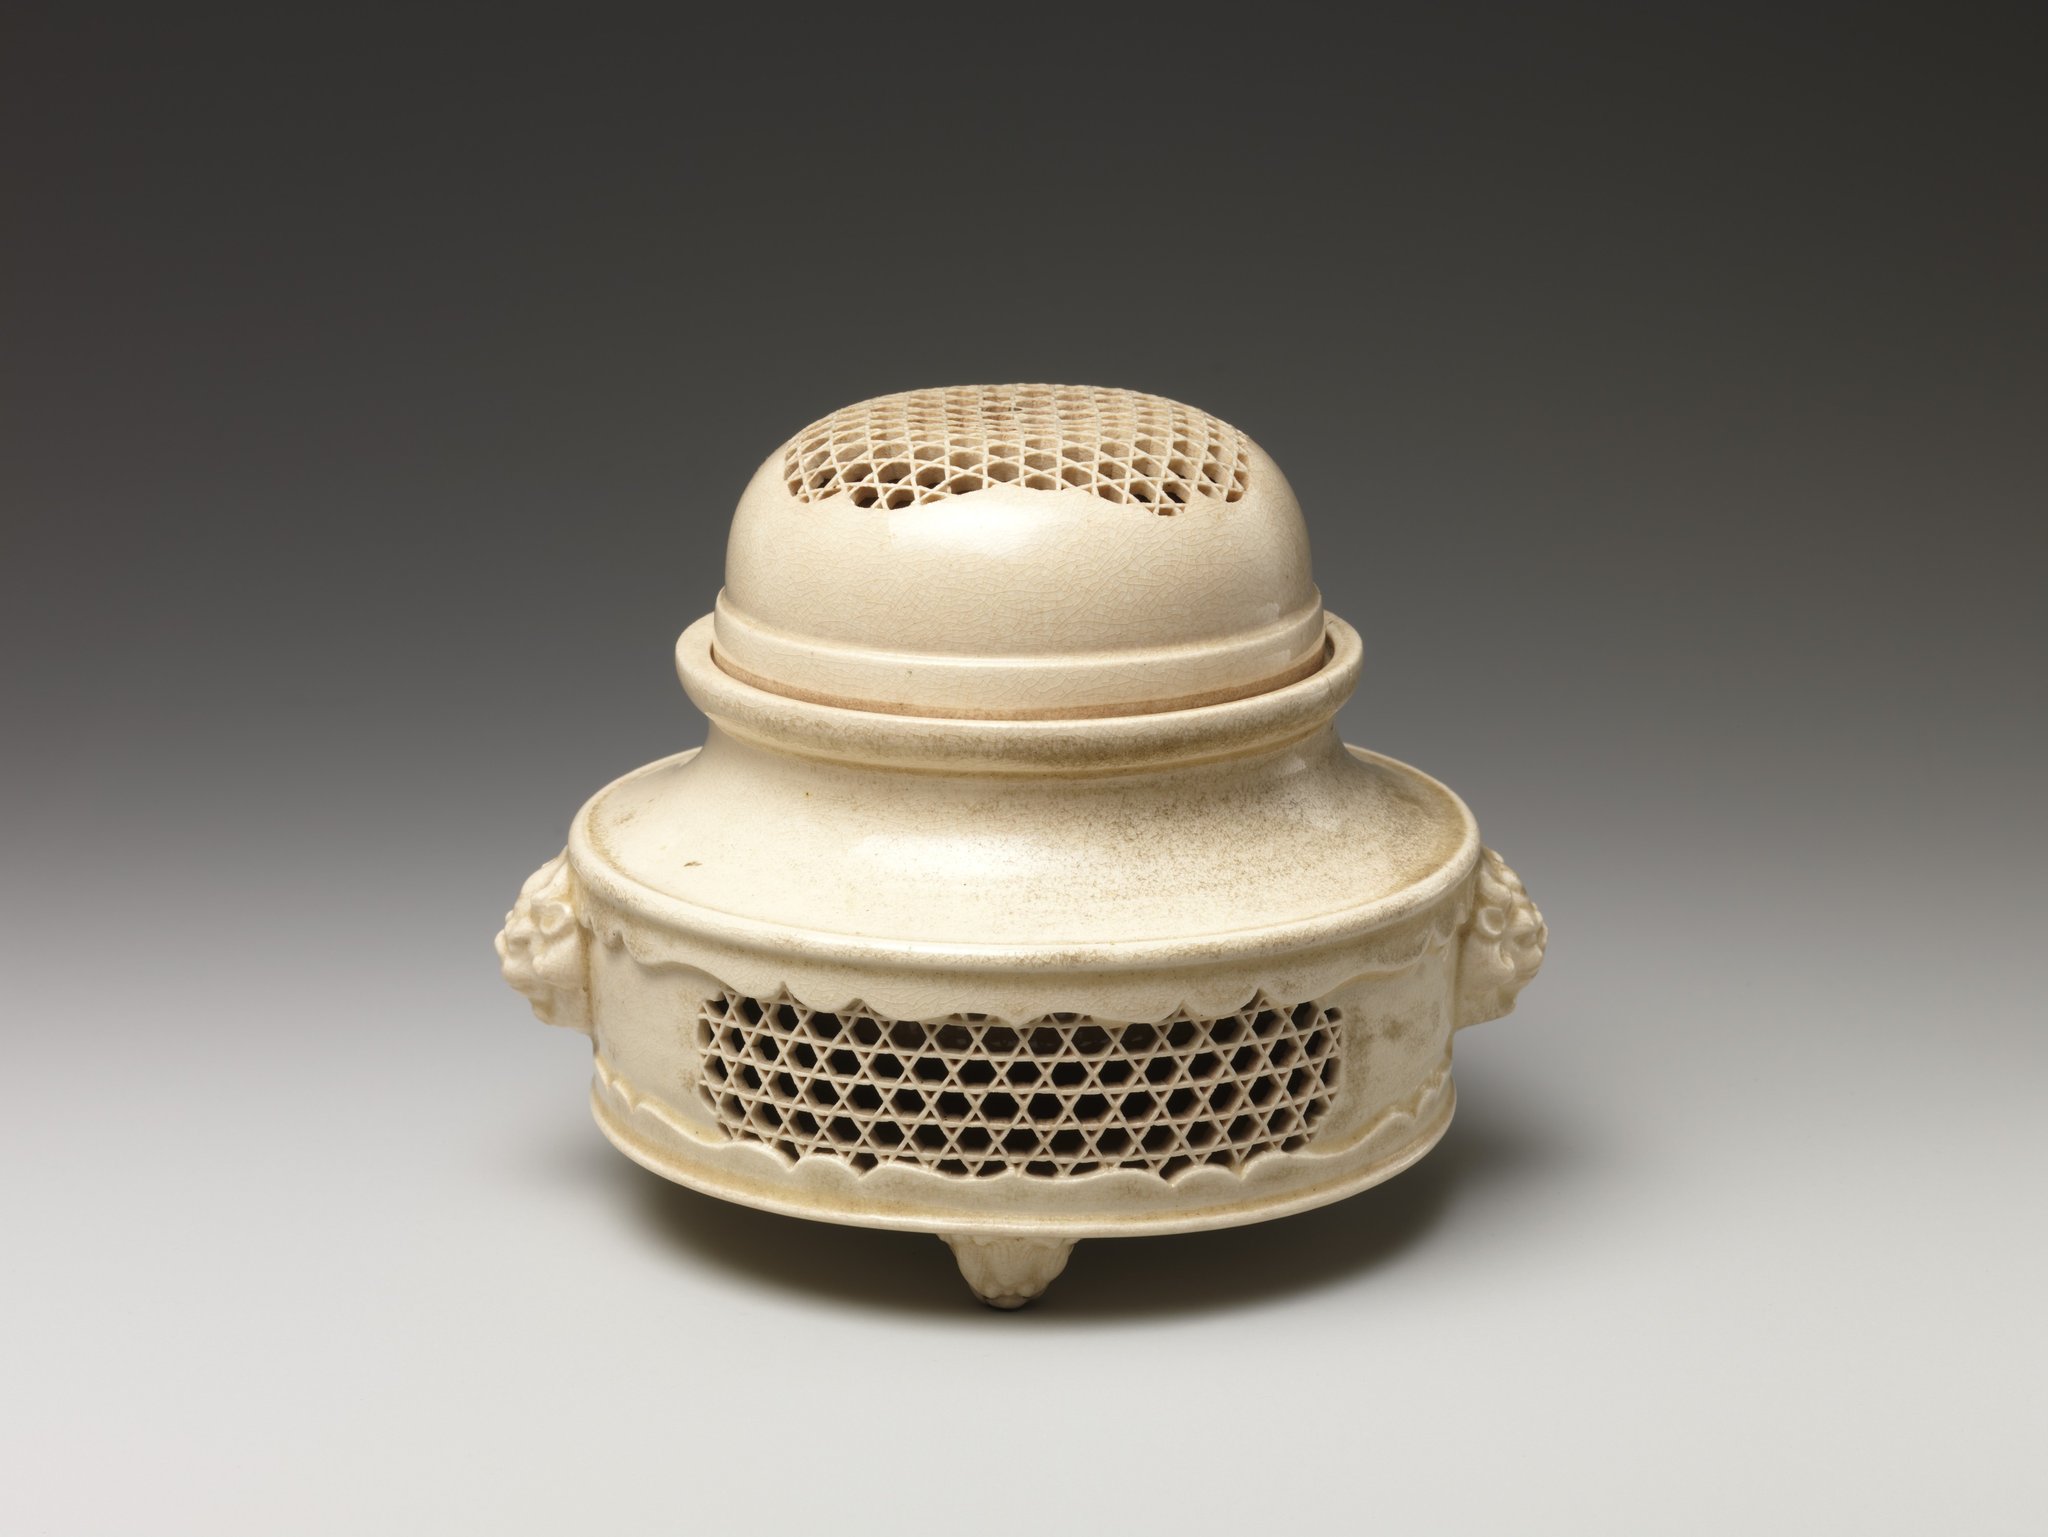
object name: incense burner koro and cover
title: Incense Burner (koro) and Cover with Molded and Reticulated Design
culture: japanese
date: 1701-1800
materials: earthenware, glaze